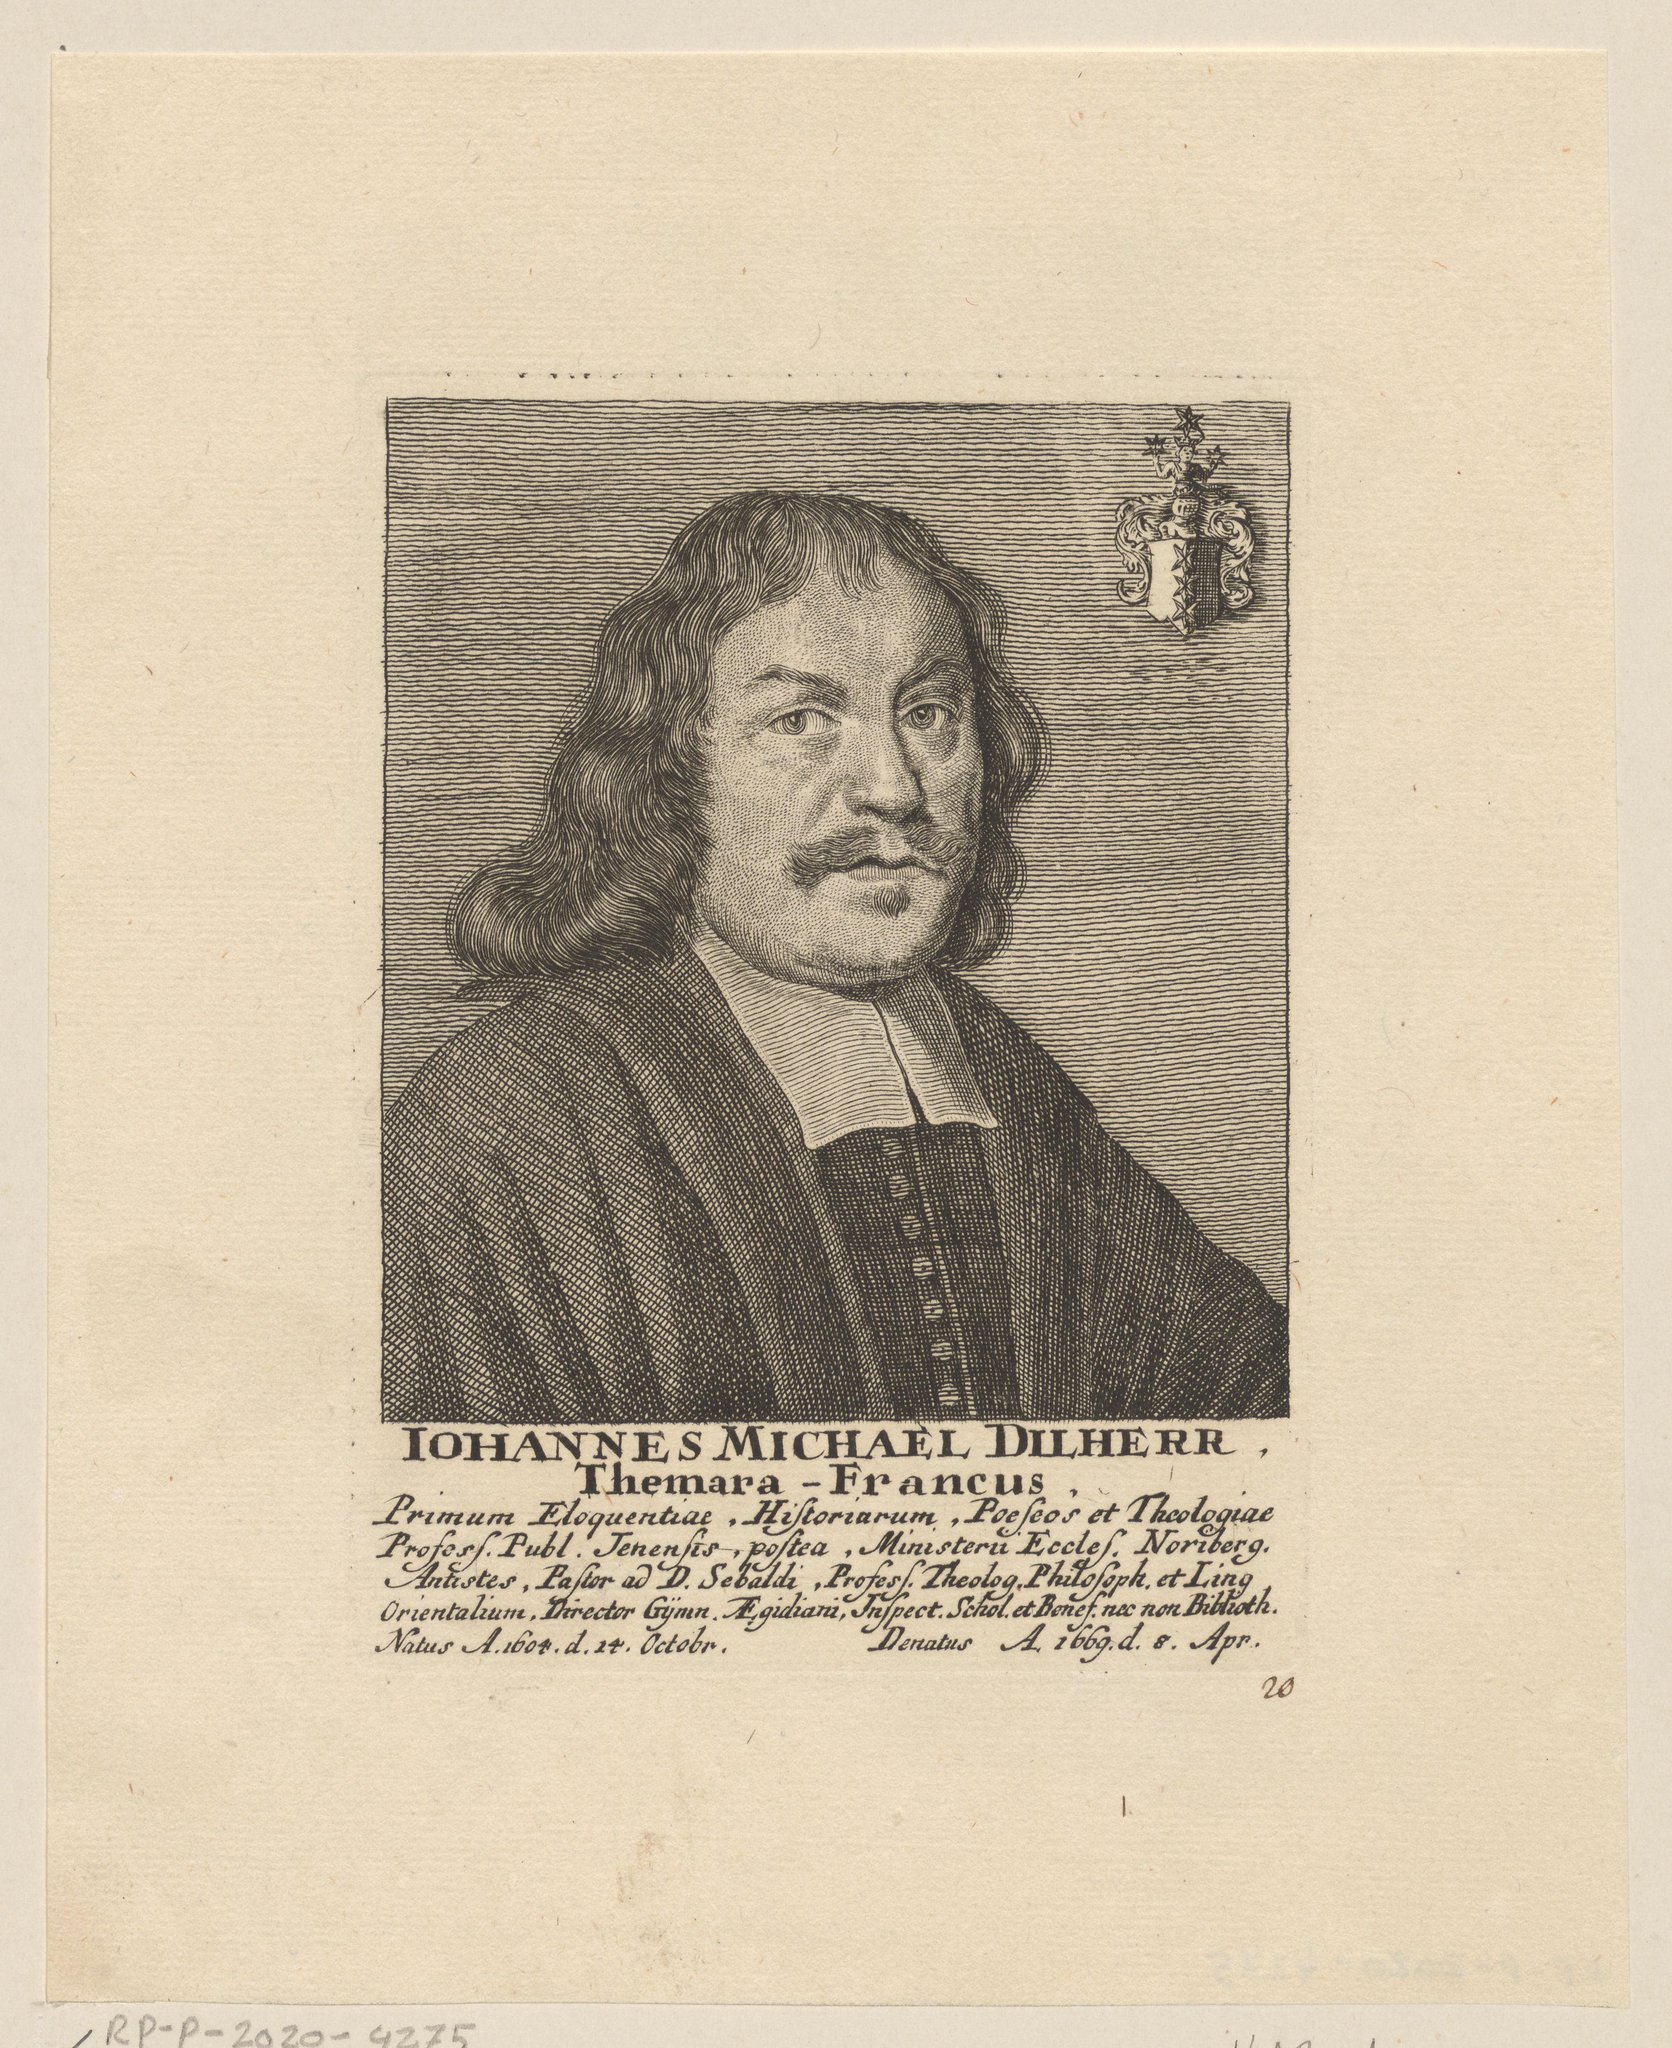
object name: print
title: Portret van Johann Michael Dilherr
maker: Anonymous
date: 1725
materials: paper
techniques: engraving, etching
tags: johann michael dilherr, theologian, historical persons, armorial bearing, heraldry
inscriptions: inscription: ‘20’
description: Prent mogelijk uit: Rothscholtz, Friedrich. Icones virorum omnium ordinum eruditione: omnique item genere et varietate artium de republica litteraria et speciatim de Academiis et Gymnasiis (...). Neurenberg: erven Johann Daniel Tauber, 1725, dl. 1.